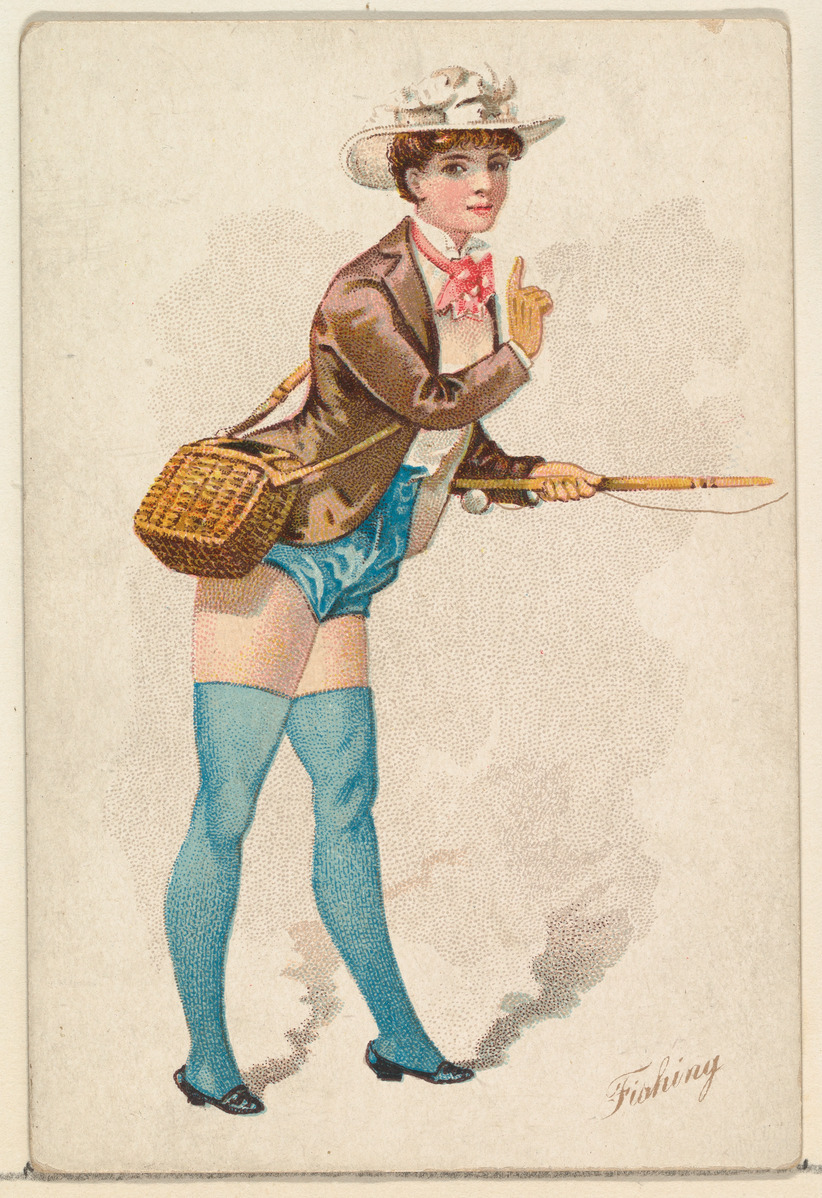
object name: print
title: Fishing, from the Pretty Athletes series (N196) issued by Wm. S. Kimball & Co.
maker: william s. kimball & company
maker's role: publisher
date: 1889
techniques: color lithograph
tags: women,athletes